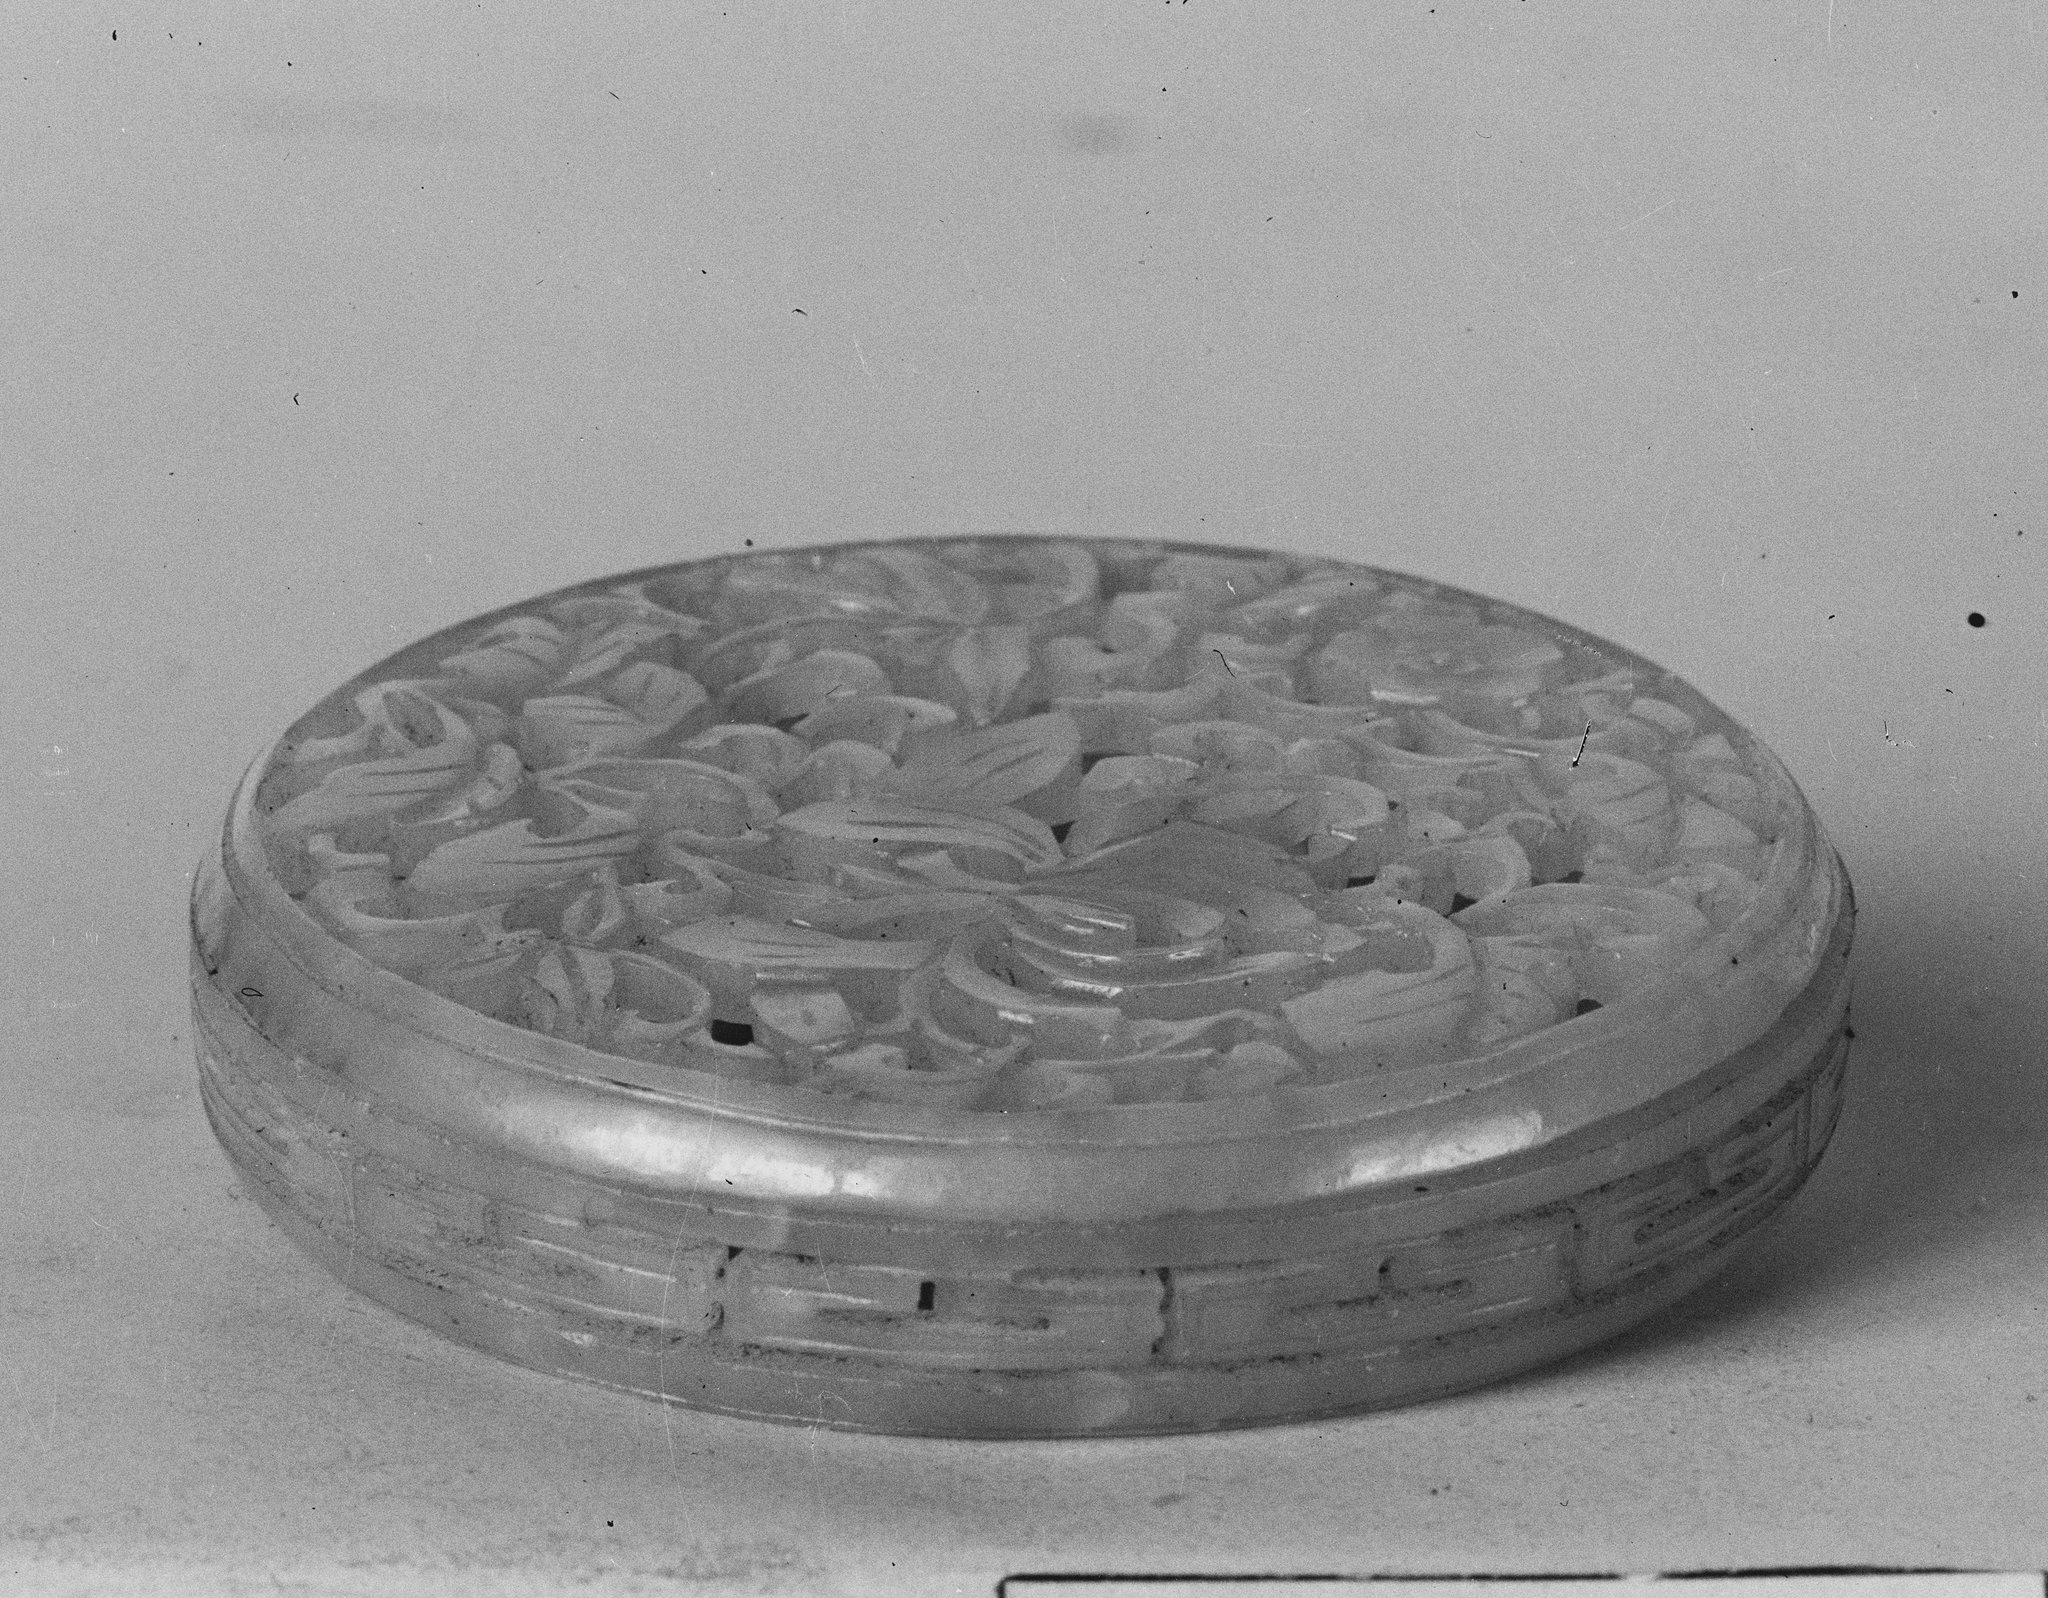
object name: covered box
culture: chinese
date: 1801-1900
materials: jade